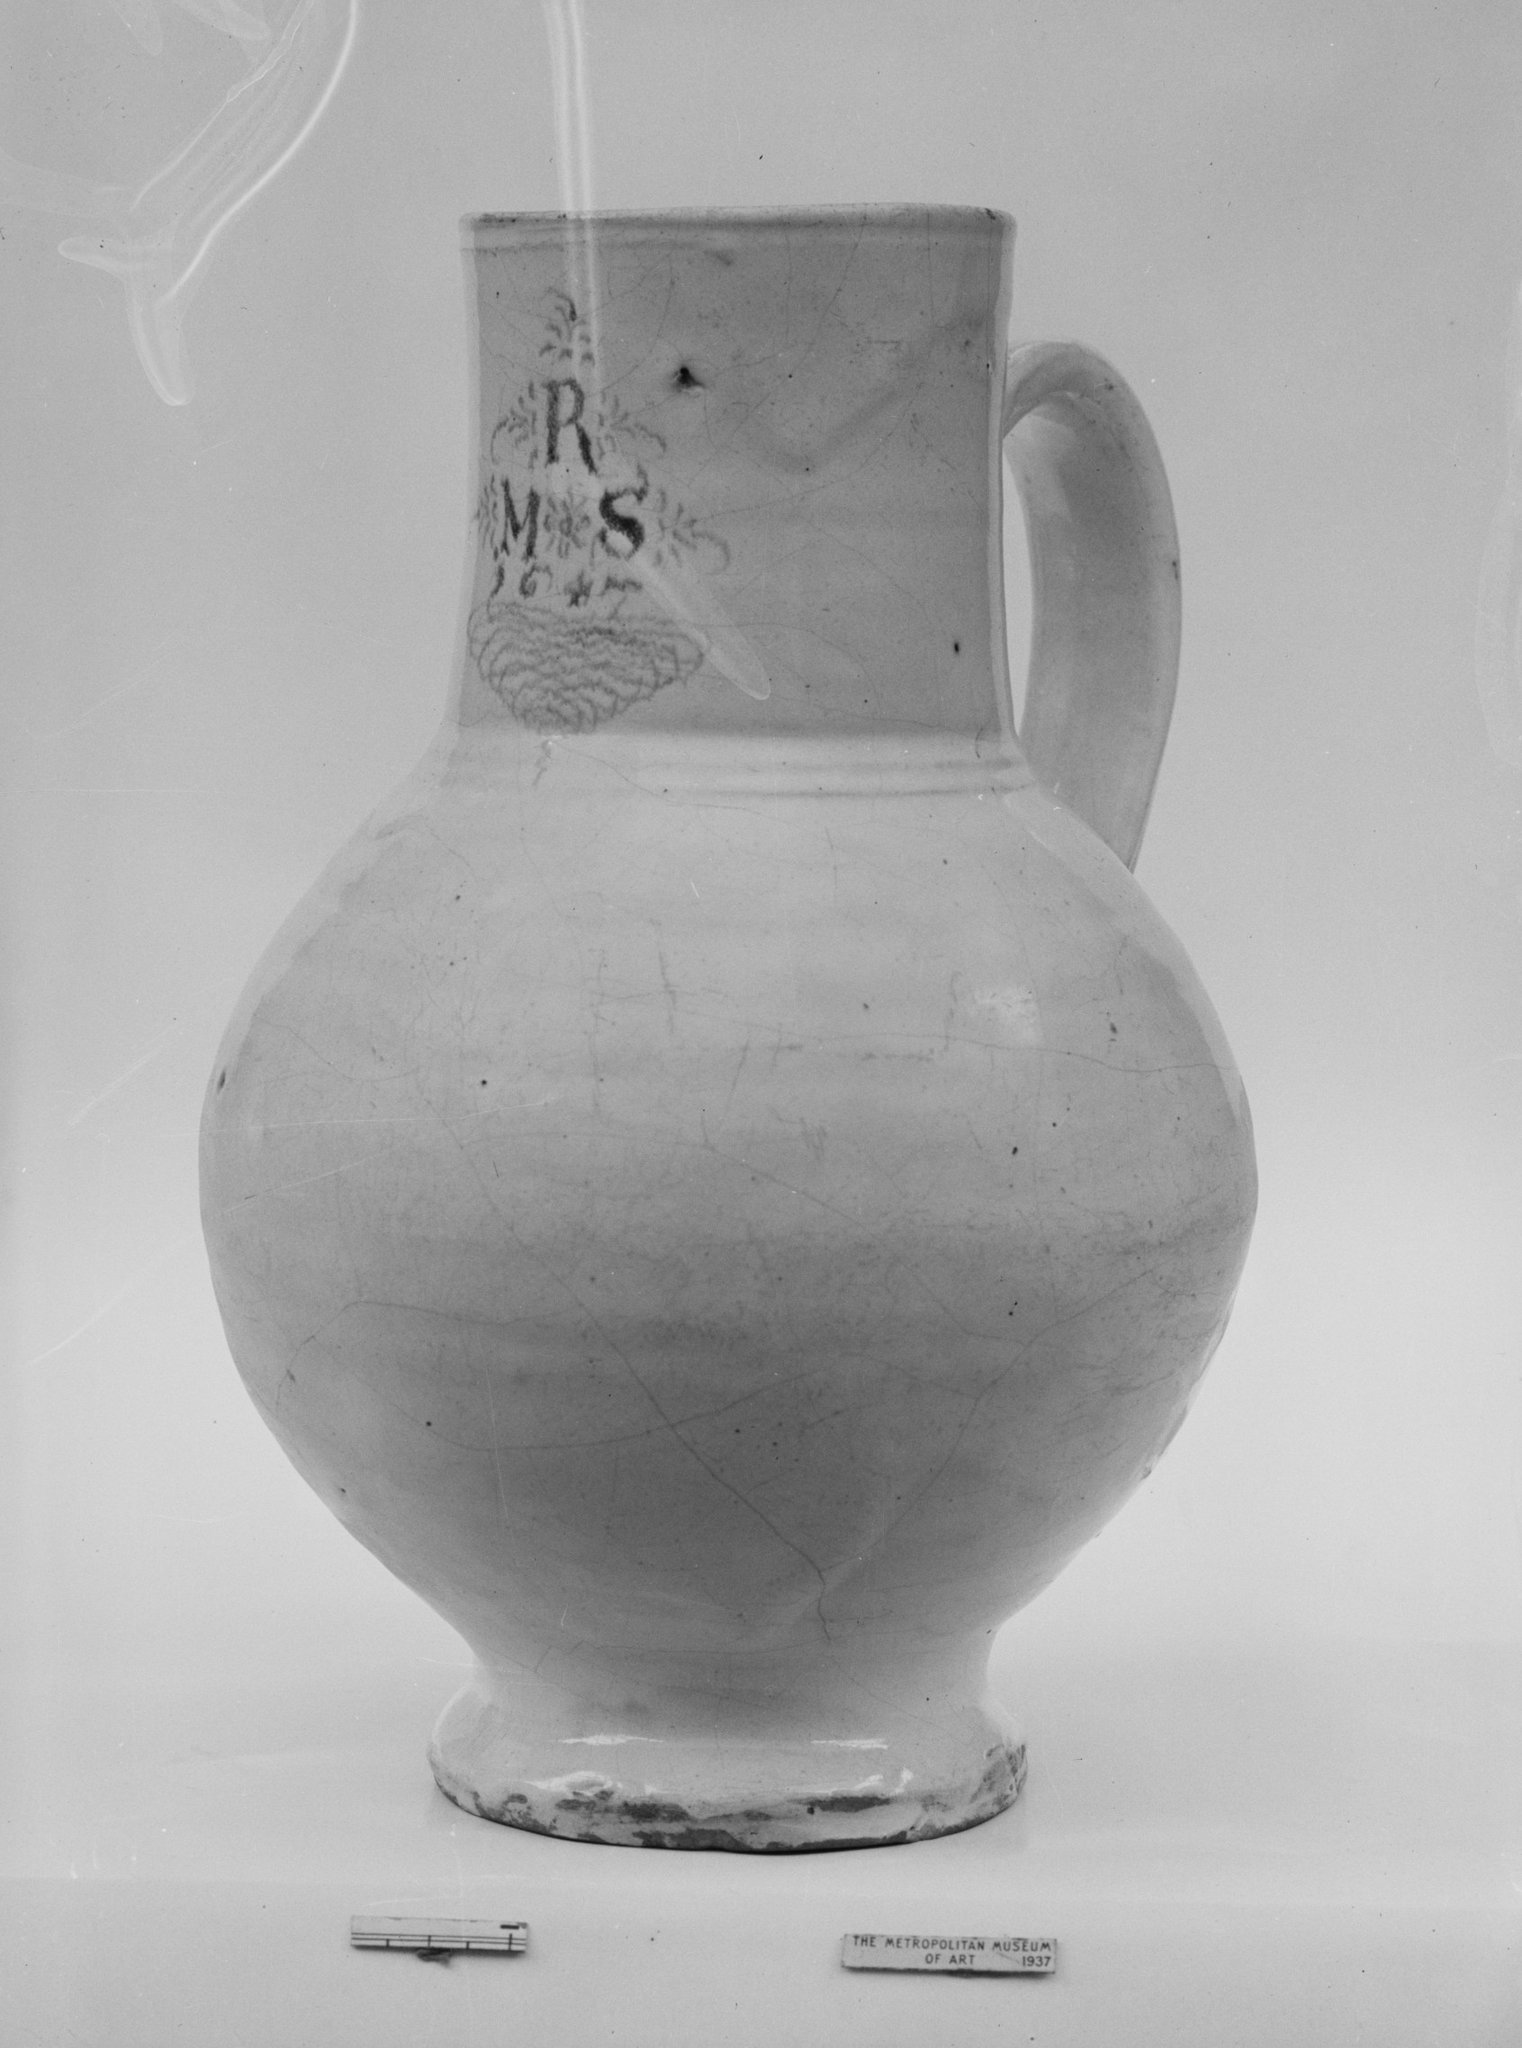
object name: jug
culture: british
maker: lambeth factories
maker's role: maker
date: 1647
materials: earthenware, tin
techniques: enamel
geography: england